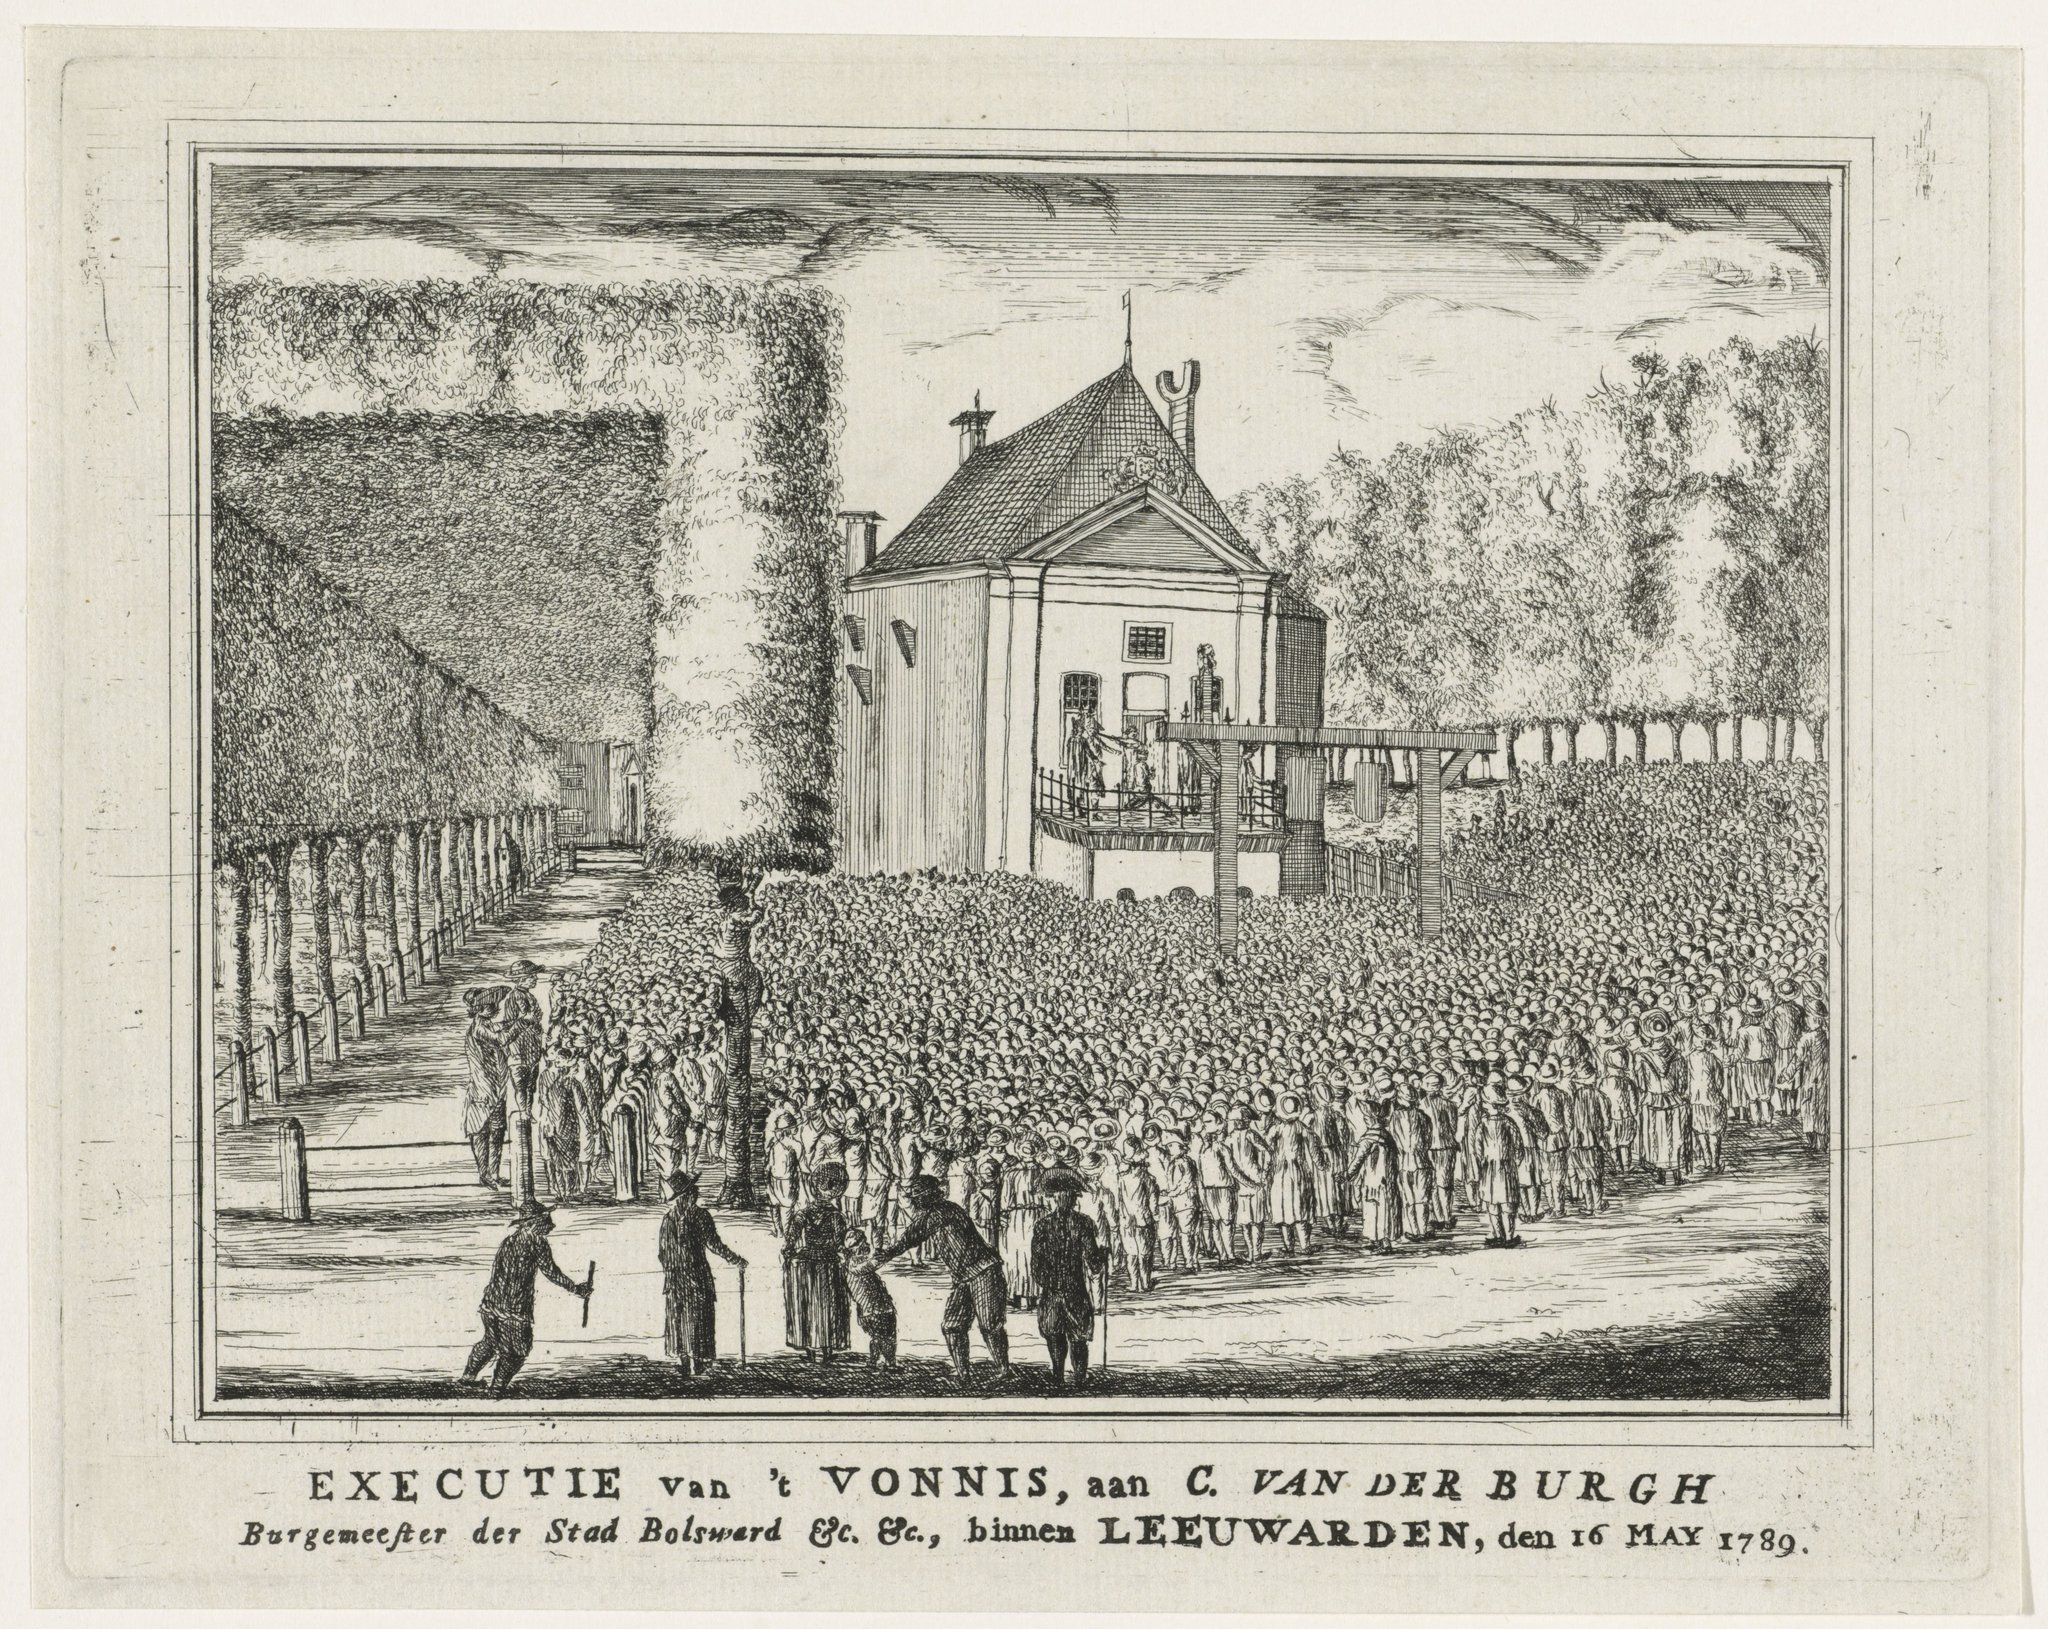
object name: print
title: Executie van 't Vonnis, aan C. van der Burgh Burgemeester der Stad Bolswerd &c. &c., binnen Leeuwarden, den 16 May 1789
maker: rienk jelgerhuis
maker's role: draughtsman, print maker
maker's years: 1729-1806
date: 1789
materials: paper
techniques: etching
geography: northern netherlands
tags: mayor, pardon, reprieve, violent death by hanging, patriots (1780-1795)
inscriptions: collector's mark: Lugt 2228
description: Terechtstelling van Cornelis van der Burg, uitgesproken patriotse burgemeester van Bolsward, te Leeuwarden op 16 mei 1789. Voor het schavot een grote massa toeschouwers. Als de burgemeester geblinddoekt knielt op het schavot houdt de beul het zwaard boven zijn hoofd en wordt het doodsvonnis omgezet in een verbanning van twintig jaar.